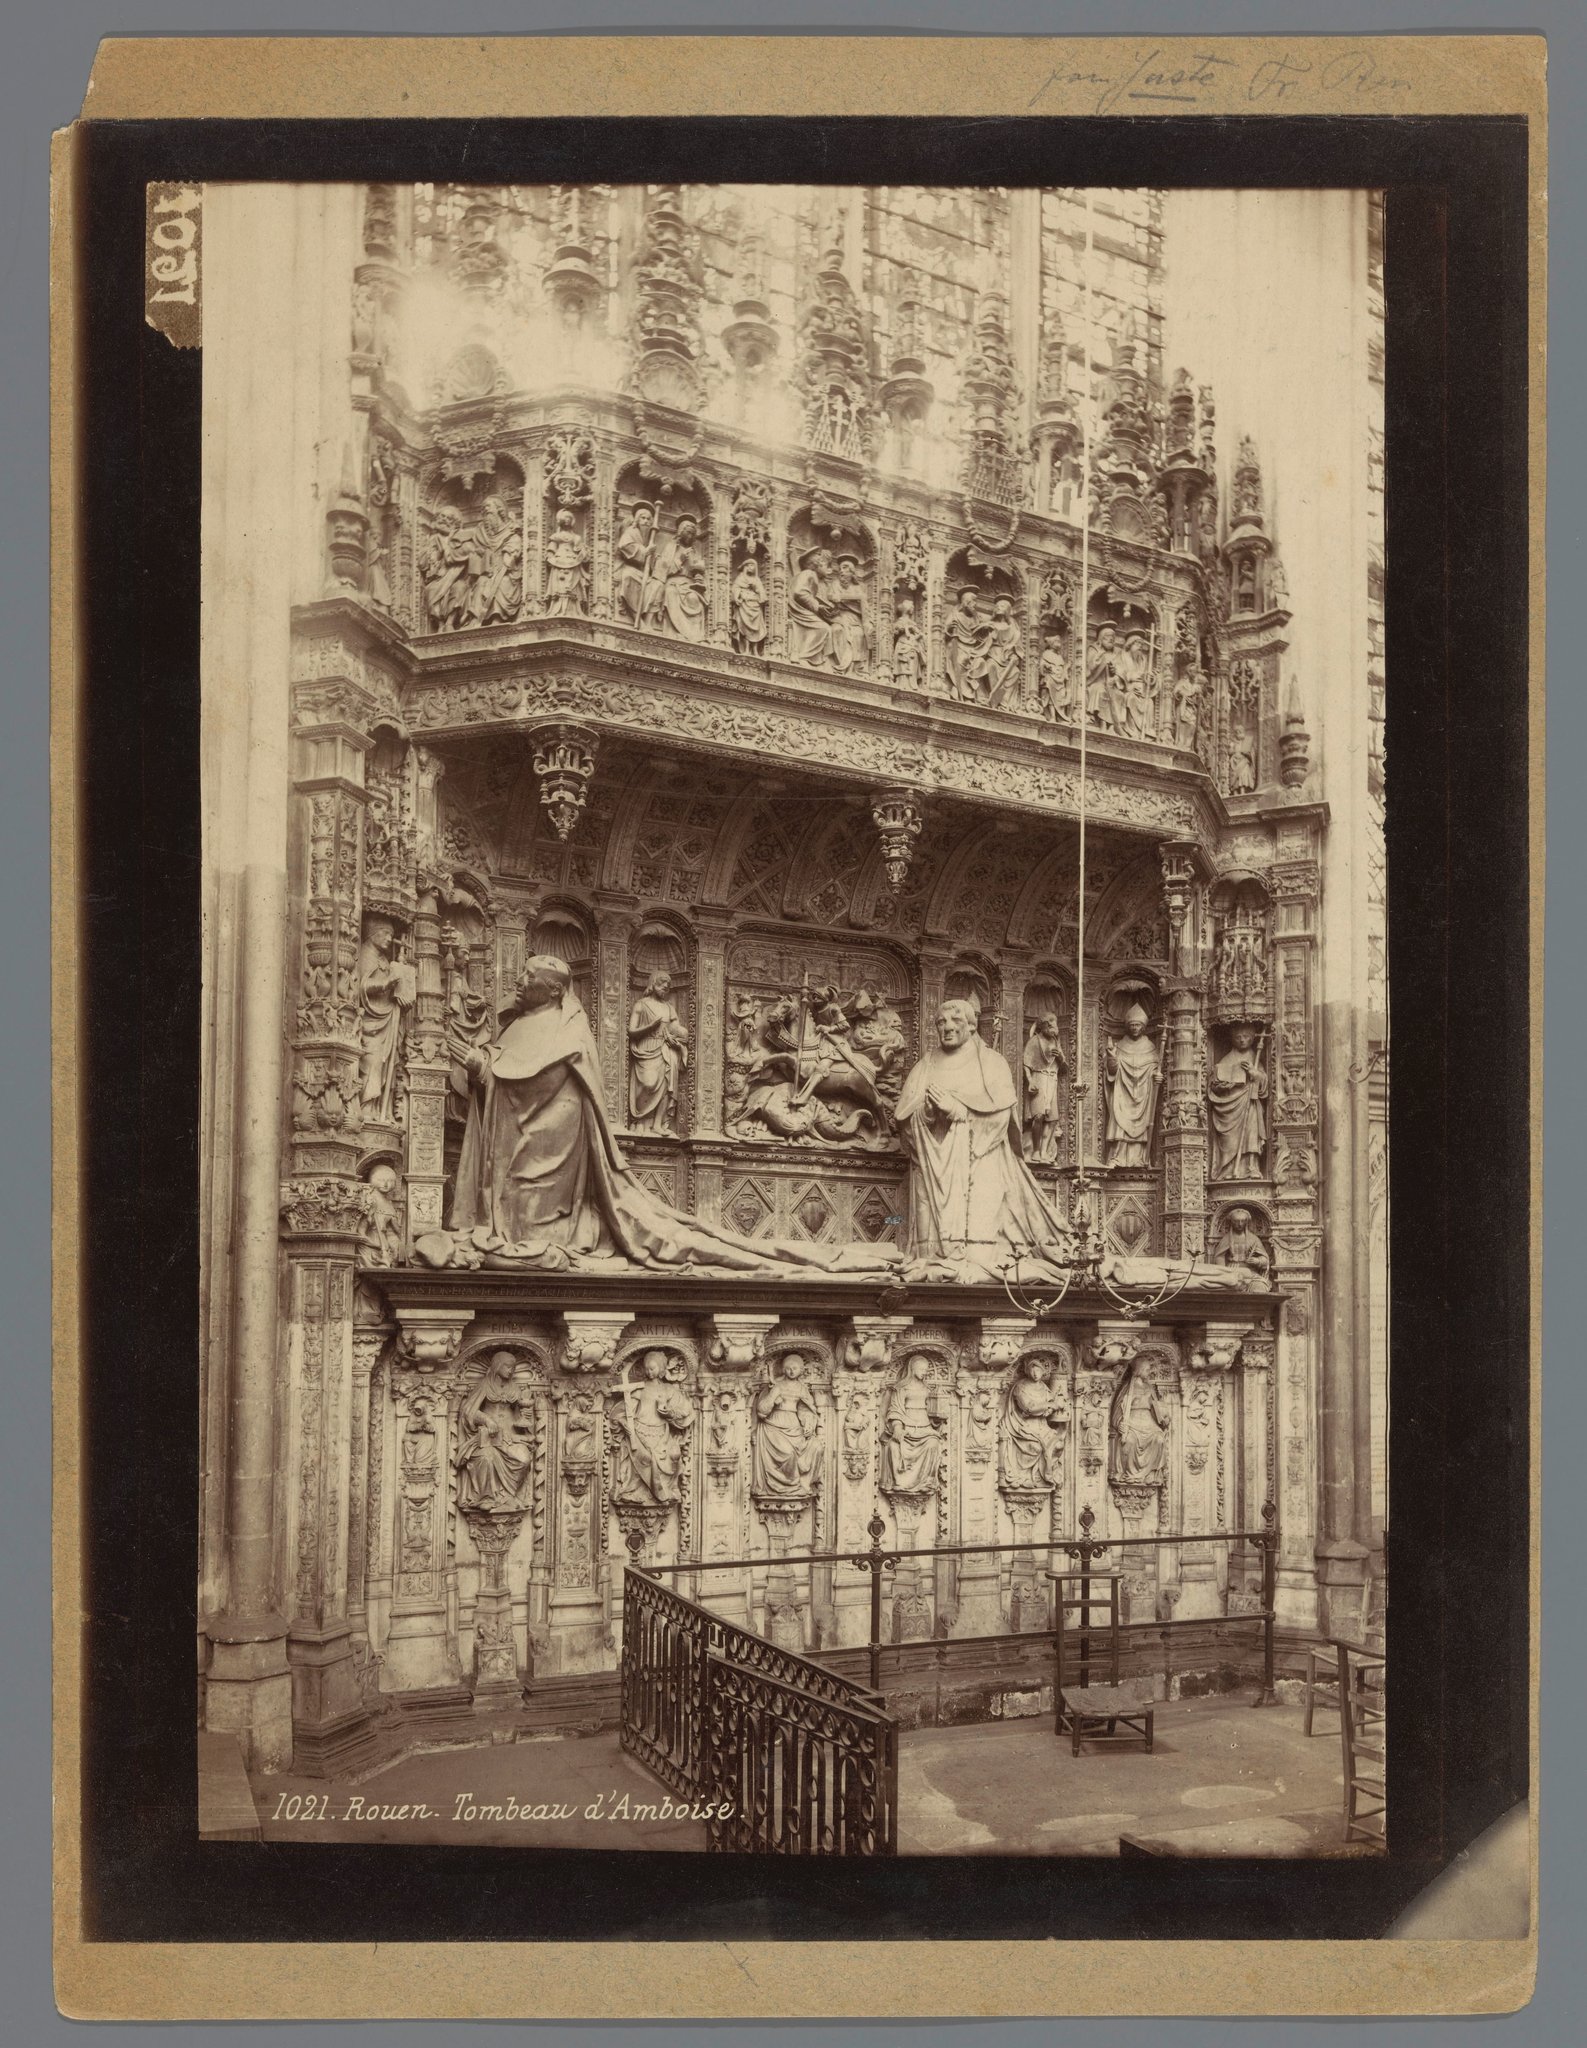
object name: photograph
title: Grafmonument van de kardinalen van Amboise in de Onze-Lieve-Vrouwekathedraal te Rouen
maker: Anonymous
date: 1875-1900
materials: cardboard, photographic support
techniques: albumen print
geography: rouen cathedral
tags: st. george and the dragon: dressed in armour and mounted on a (white) horse he brandishes his sword (his lance lies already broken on the ground); the princess nearby may be shown praying or fleeing, grave, tomb, interior of church, sculpture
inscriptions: collector's mark: Lugt 3937, inscription: ‘fam Juste Fr. Ren.’, number: ‘1201’, number: ‘1021.’, inscription: ‘stijlkast fl XII en XIII’